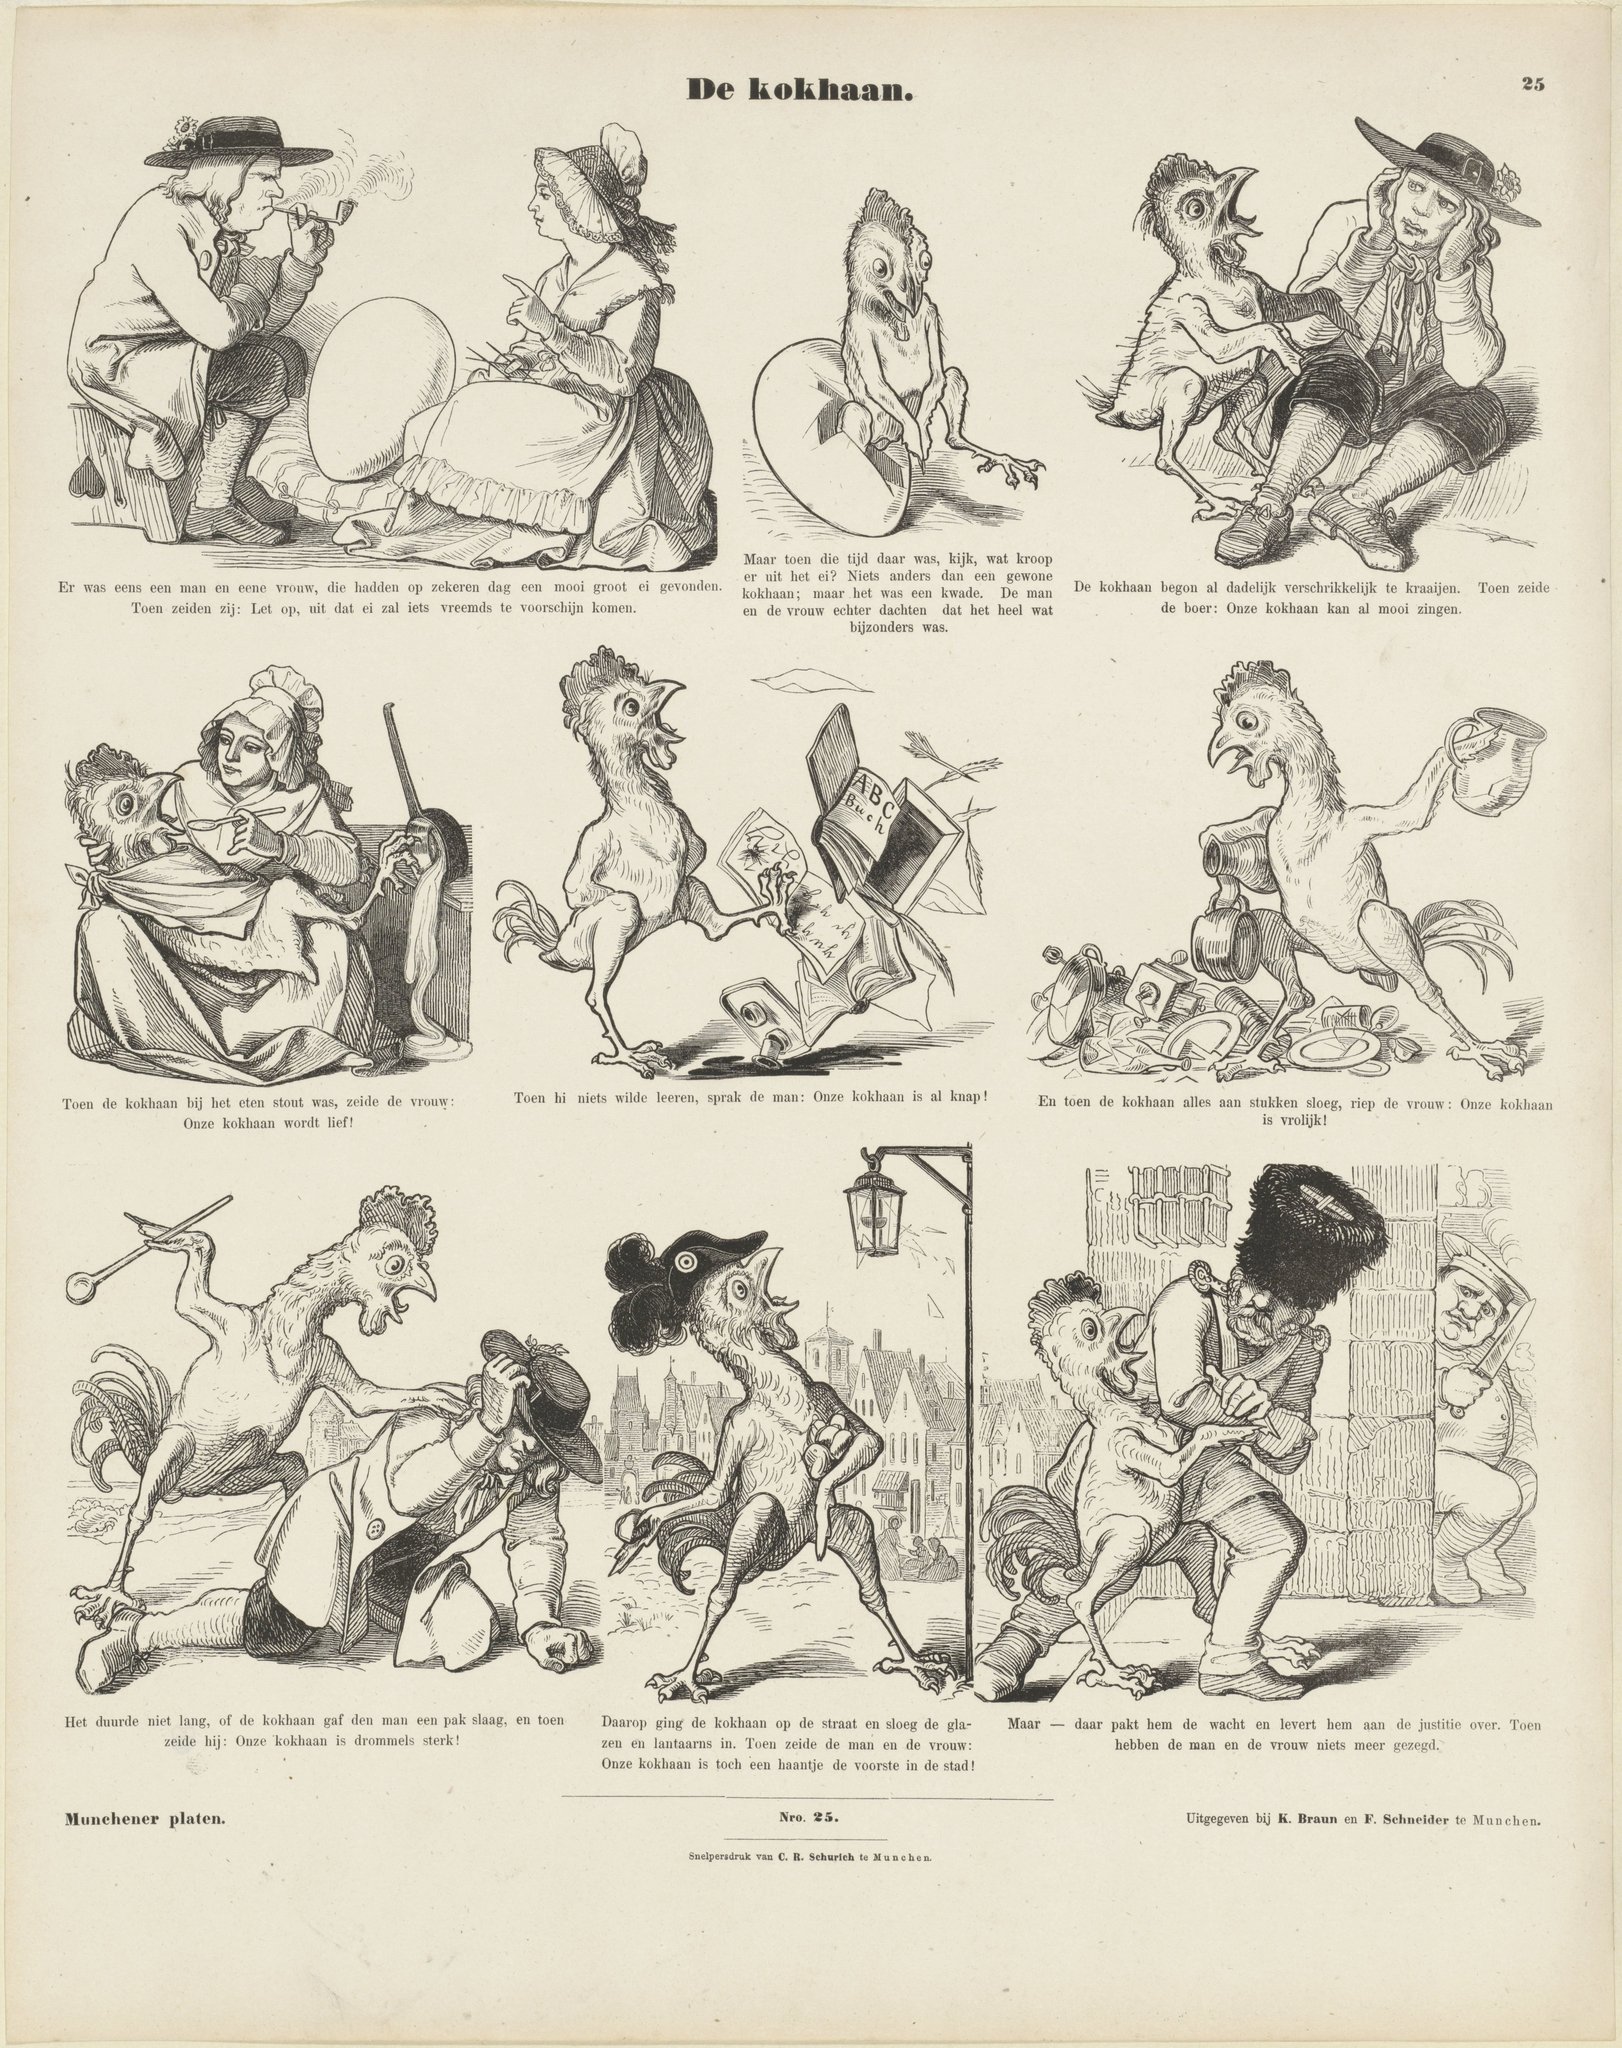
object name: popular print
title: Munchener platen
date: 1843-1920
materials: paper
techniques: letterpress printing, engraving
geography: munich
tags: fowl (cock, hen, chicken, etc.)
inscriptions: collector's mark: Lugt 2760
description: Blad met 9 voorstellingen over het leven van een haan. De haan wordt zo verwend dat hij het slechte pad op gaat. Het loopt slecht met hem af. Onder elke afbeelding een onderschrift. Genummerd midden onder: Nr. 25. Genummerd rechtsboven: 25.